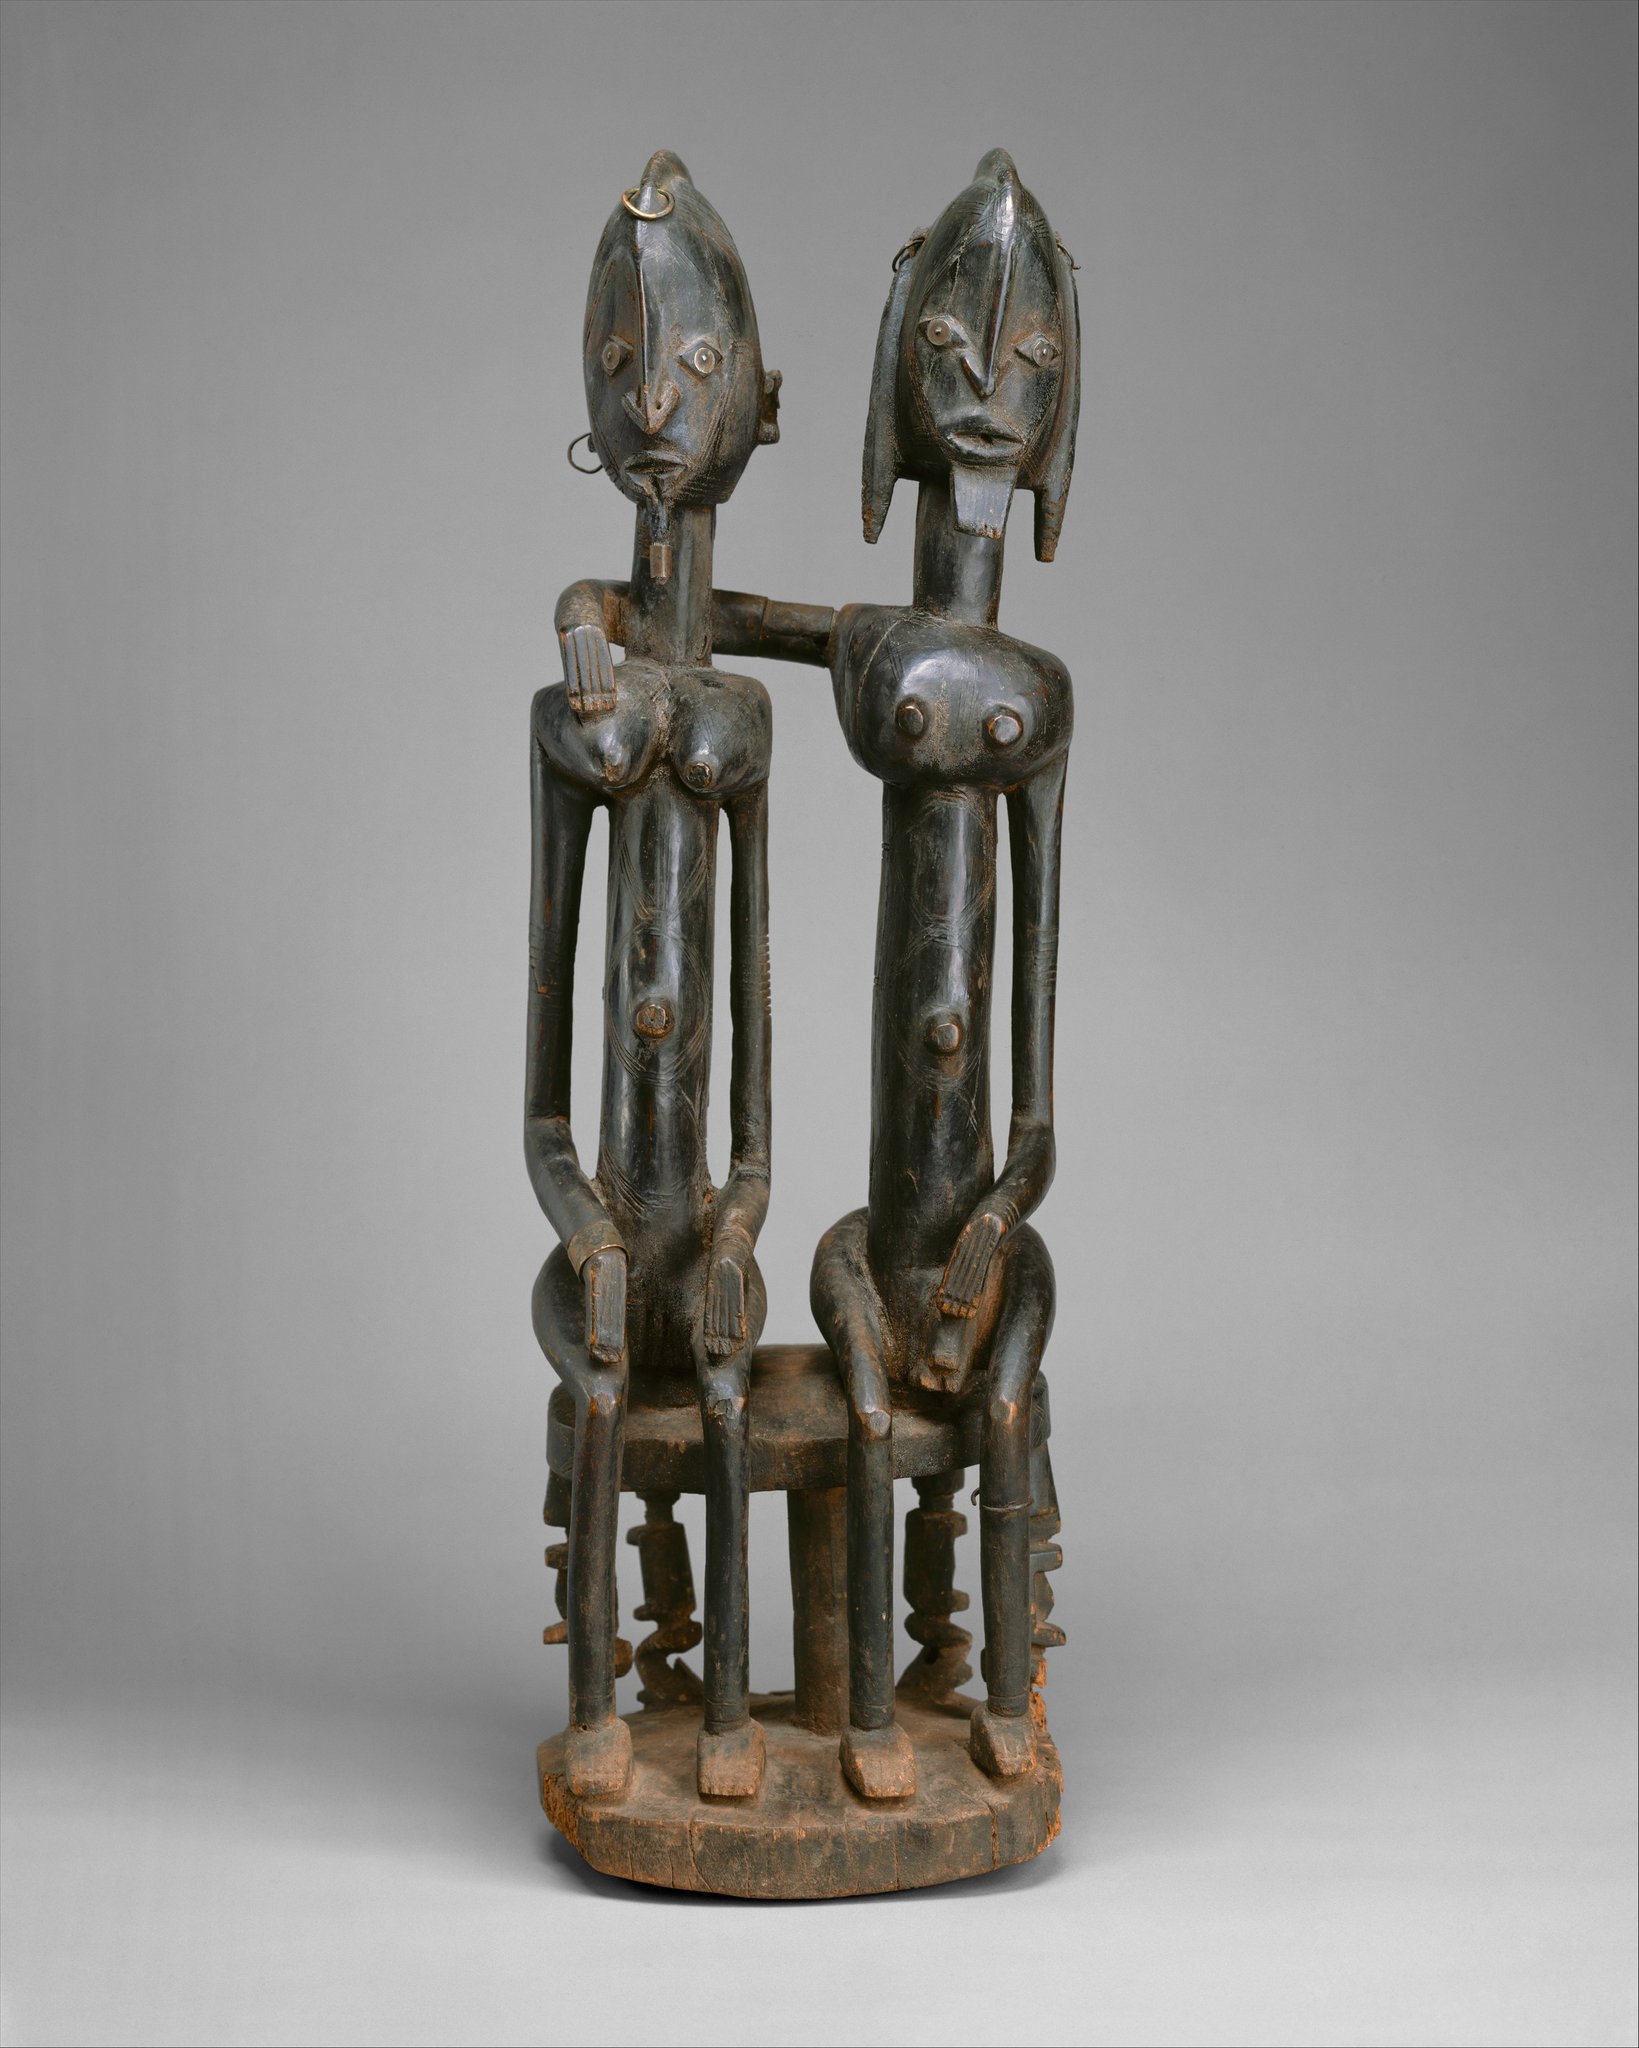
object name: couple figure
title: Seated couple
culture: dogon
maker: "barnes foundation master"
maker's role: artist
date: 1701-1833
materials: copper, metal alloy, wood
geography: mali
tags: couples,men,male nudes,women,female nudes